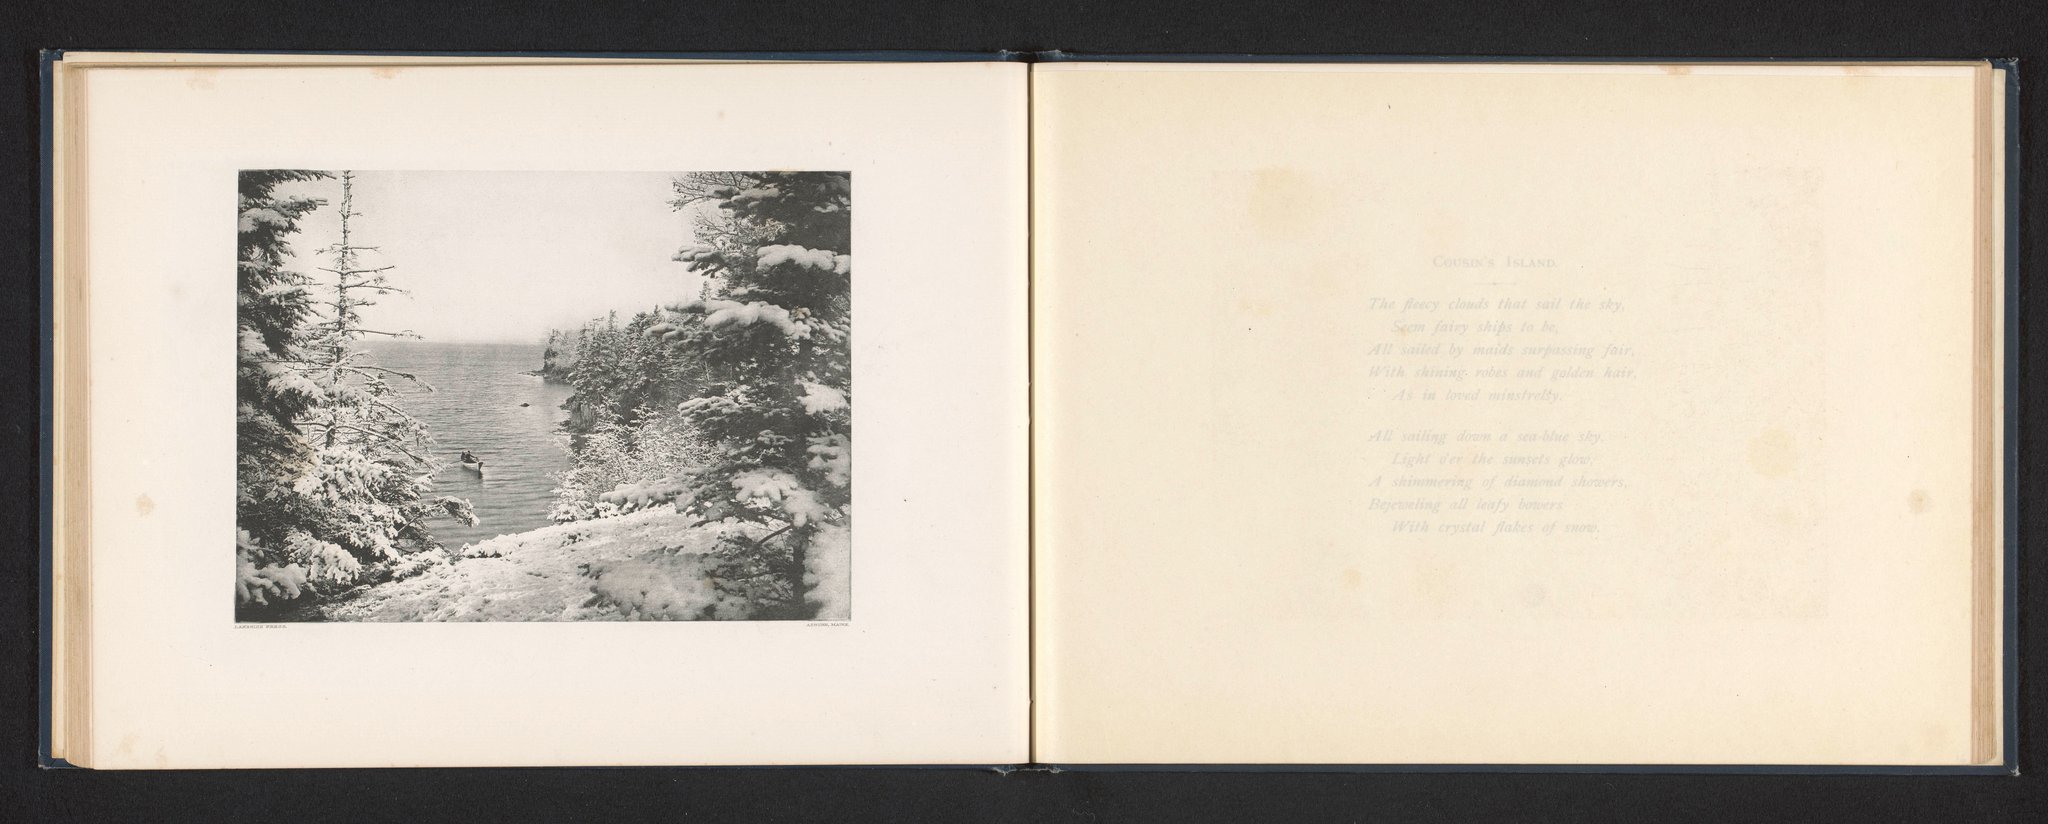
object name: page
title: Gezicht op de Casco Bay vanaf Cousins Island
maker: Anonymous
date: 1880-1890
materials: paper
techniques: photoaquatint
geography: cousins island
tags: gulf, bay, island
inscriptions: inscription: ‘Cousin's Island. (...)’